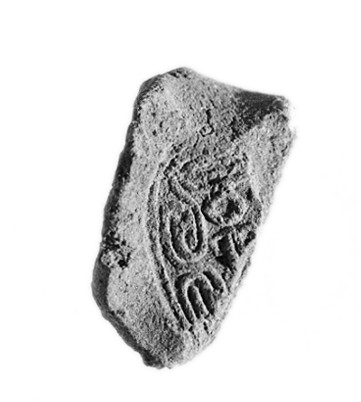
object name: sealing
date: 1981-1640 BCE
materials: mud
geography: egypt